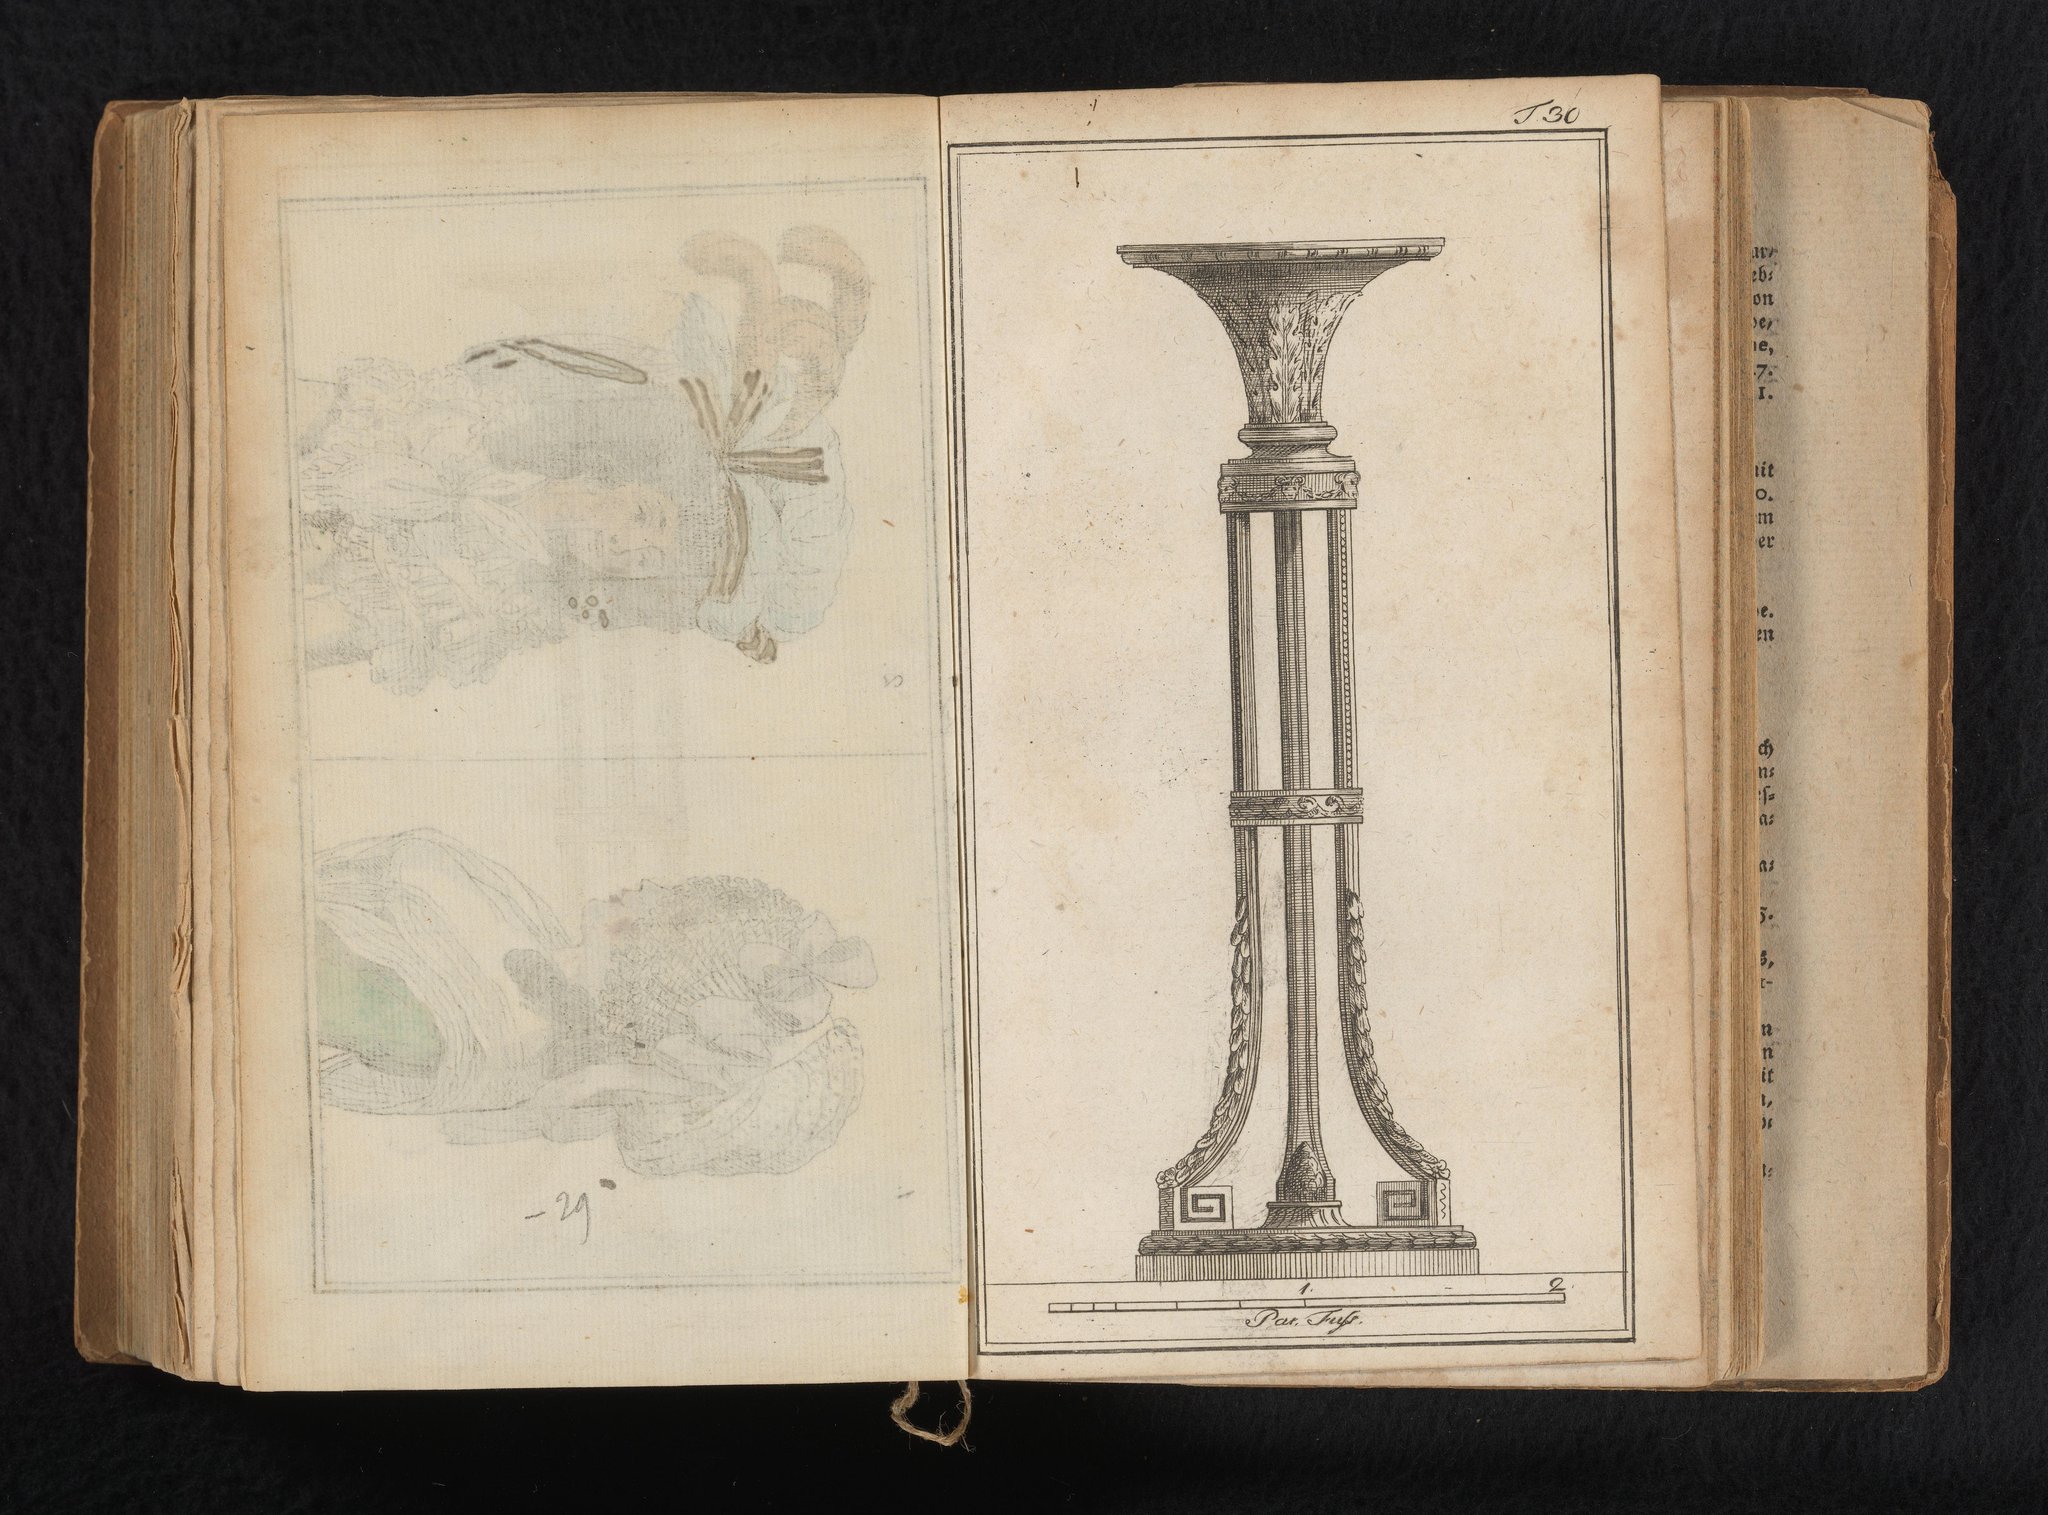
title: Journal des Luxus und der Moden 1788, Band III, T.30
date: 1788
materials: paper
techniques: etching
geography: weimar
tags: fashion plates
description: Prent uit het modetijdschrift Journal des Luxus und der Moden, uitgegeven door Friedrich Justin Bertuch en Georg Melchior Kraus, Weimar, 1786-1826.